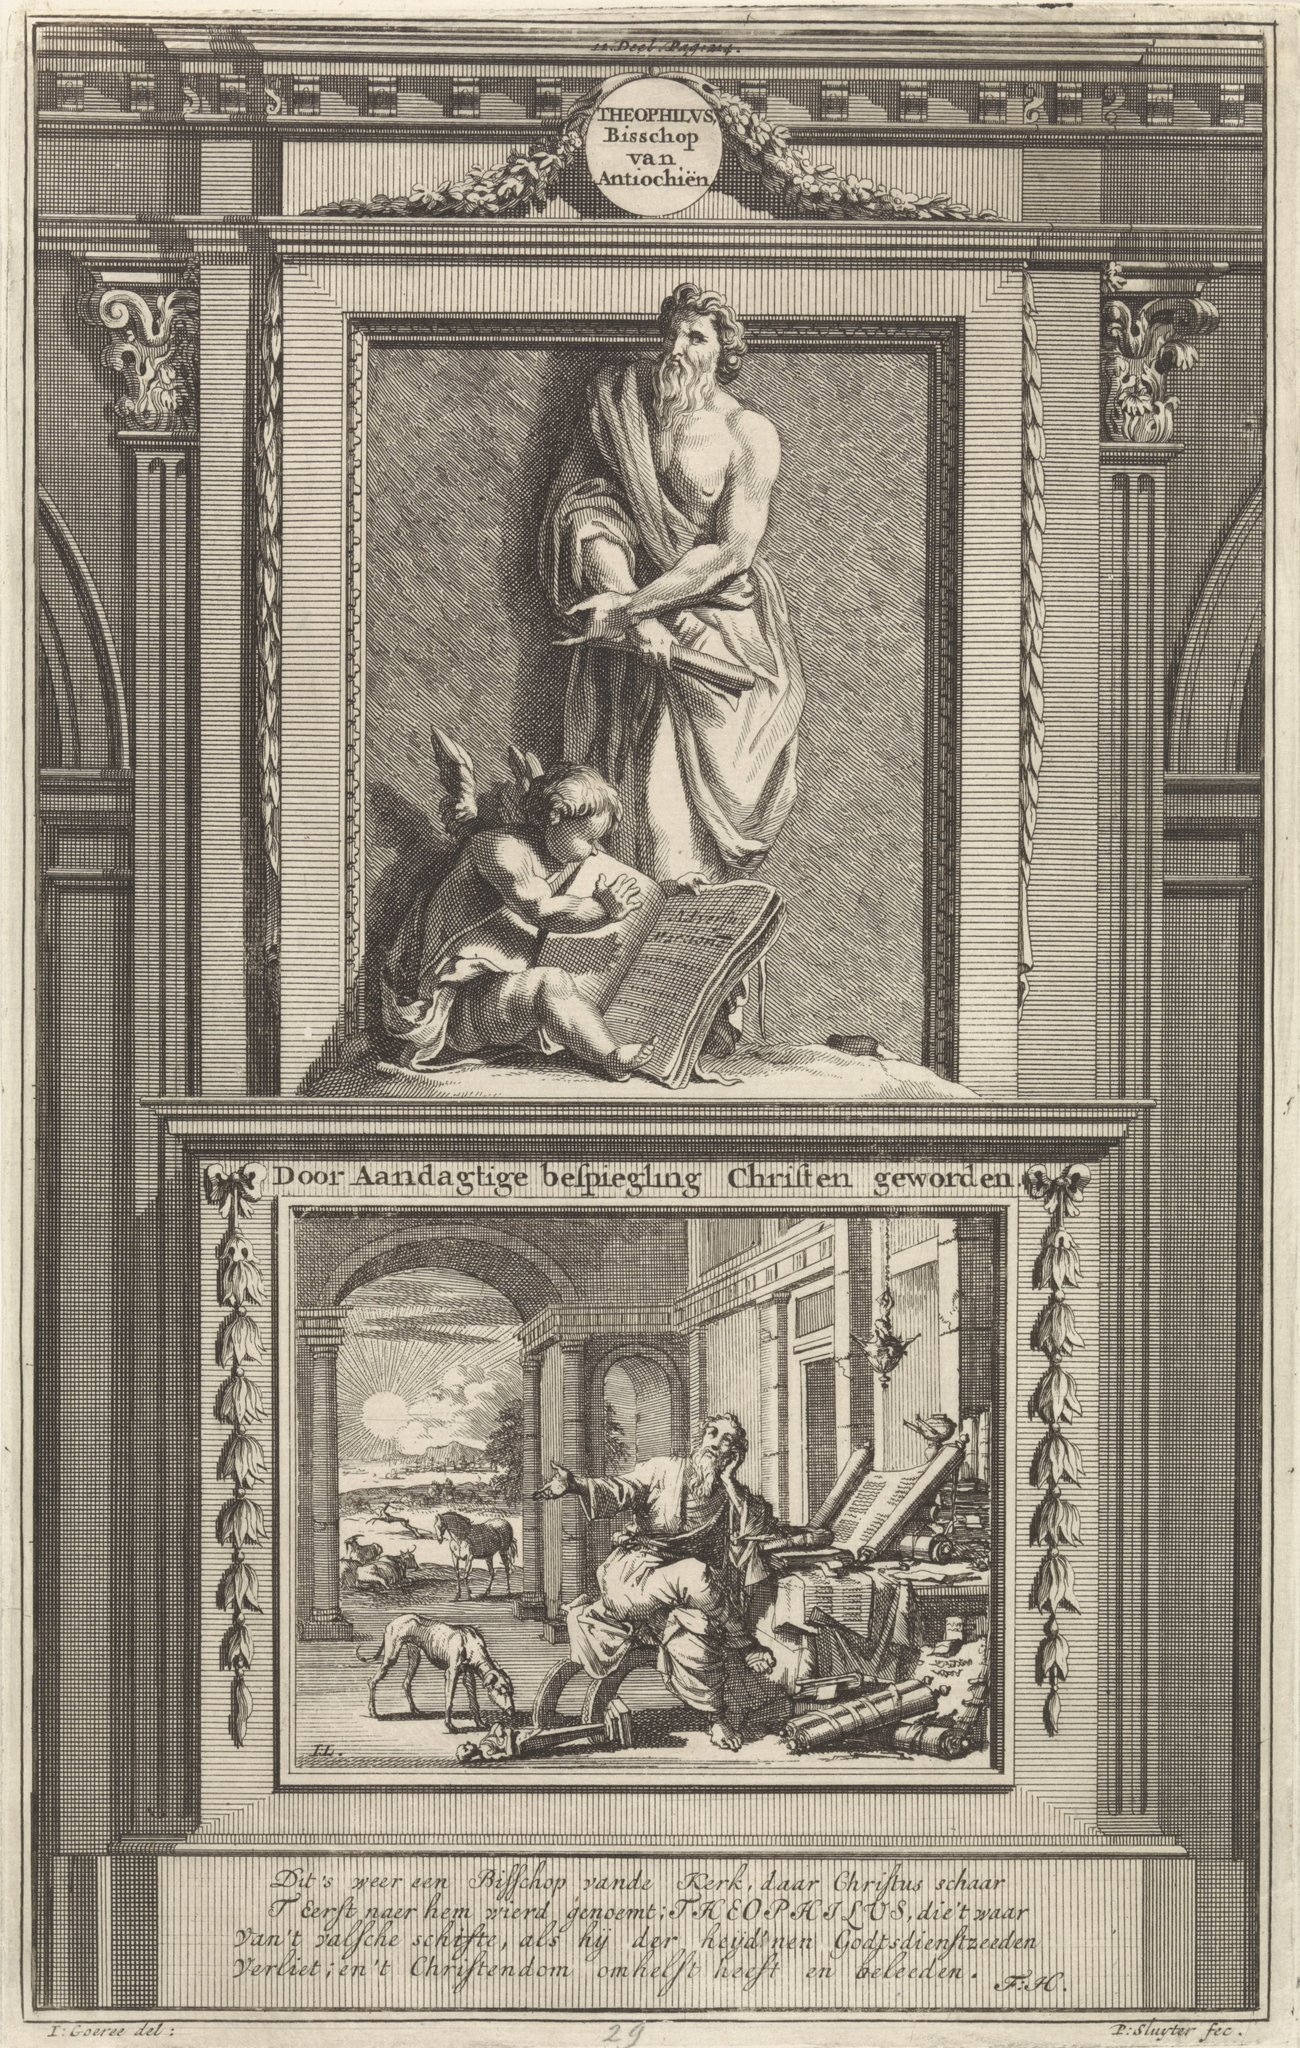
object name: print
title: Theophilus, Bisschop van Antiochiën Door Aandagtige bespiegling Christen geworden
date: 1698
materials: paper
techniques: engraving, etching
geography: amsterdam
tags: male saints (with name), private worship and religious study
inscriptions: number: ‘29’, collector's mark: Lugt 2228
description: De heilige apologeet Theophilus van Antiochië met een opgerold papier in zijn handen. Aan zijn voeten bestudeert een engel een boek. Theophilus staat op een sokkel waar op de voorzijde zijn studie van christelijke geschriften in beeld is gebracht. Prent middenboven gemerkt: II. Deel. Pag: 214.